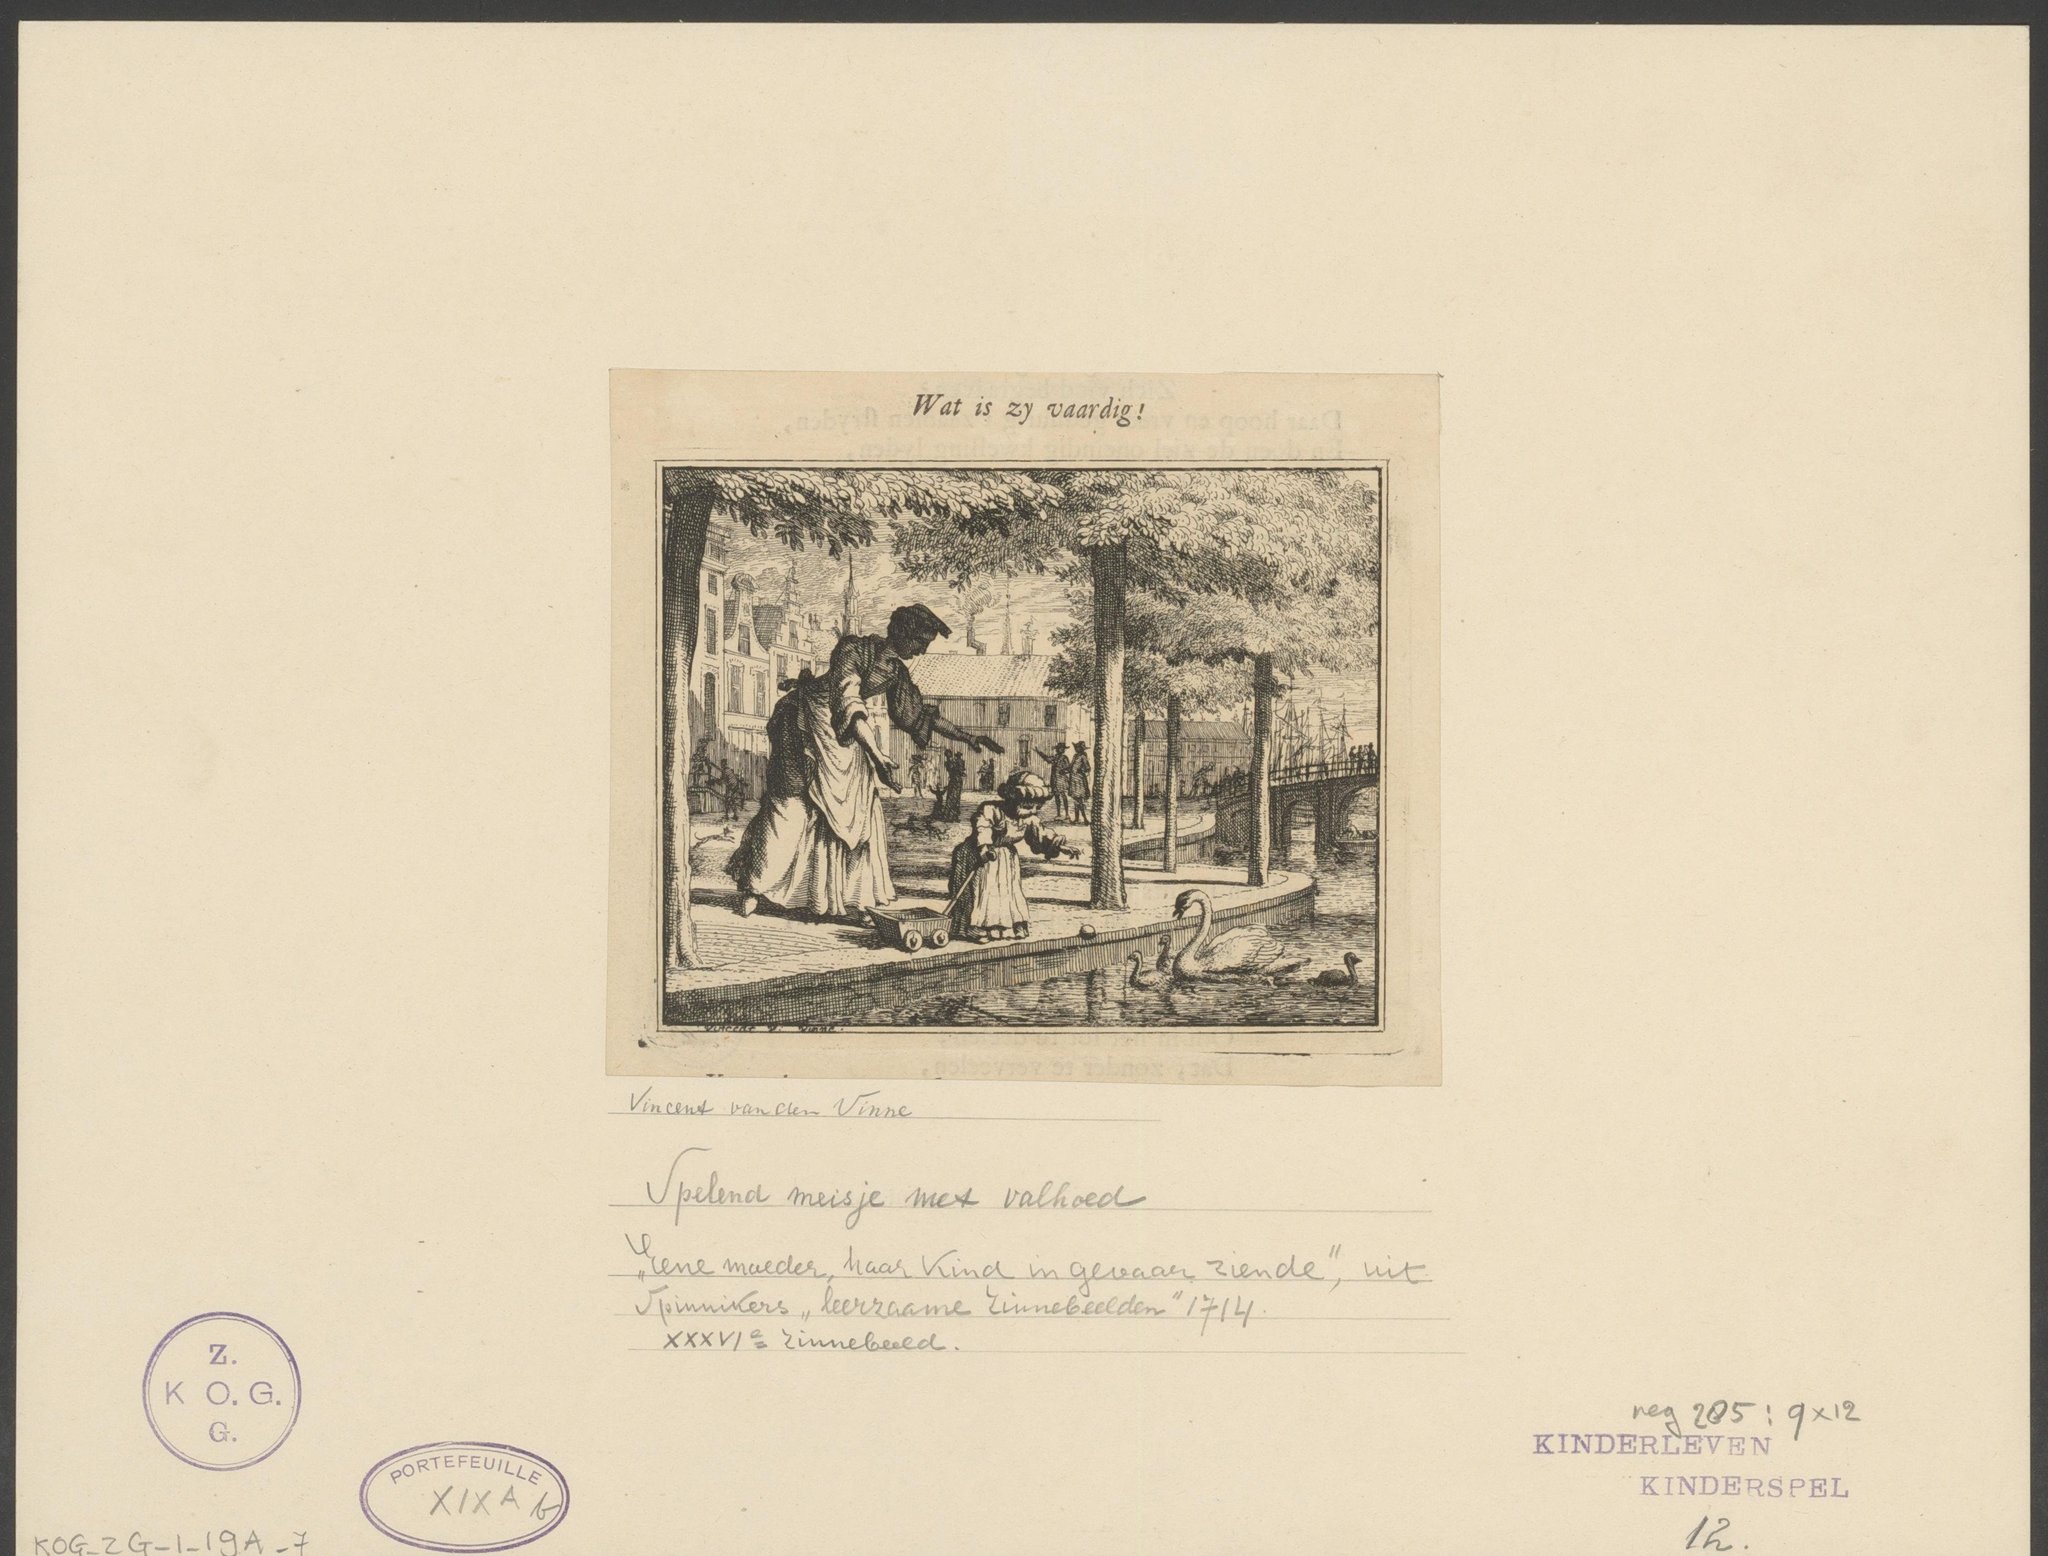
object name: print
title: Meisje kijkt naar de zwanen aan het water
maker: vincent laurensz. van der vinne (ii)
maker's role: draughtsman, print maker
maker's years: 1686-1742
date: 1714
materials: paper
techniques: etching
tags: water-birds: swan, child, canal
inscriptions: stamp, stamp, collector's mark: Lugt 1641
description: Onderwerpsrubrieken binnen de Atlas Zeden en Gewoonten: Zeden en Gewoonten in Engeren Zin, Des menschen beging, midden en einde, Kinderleven – Kinderspel en Kinderprenten.